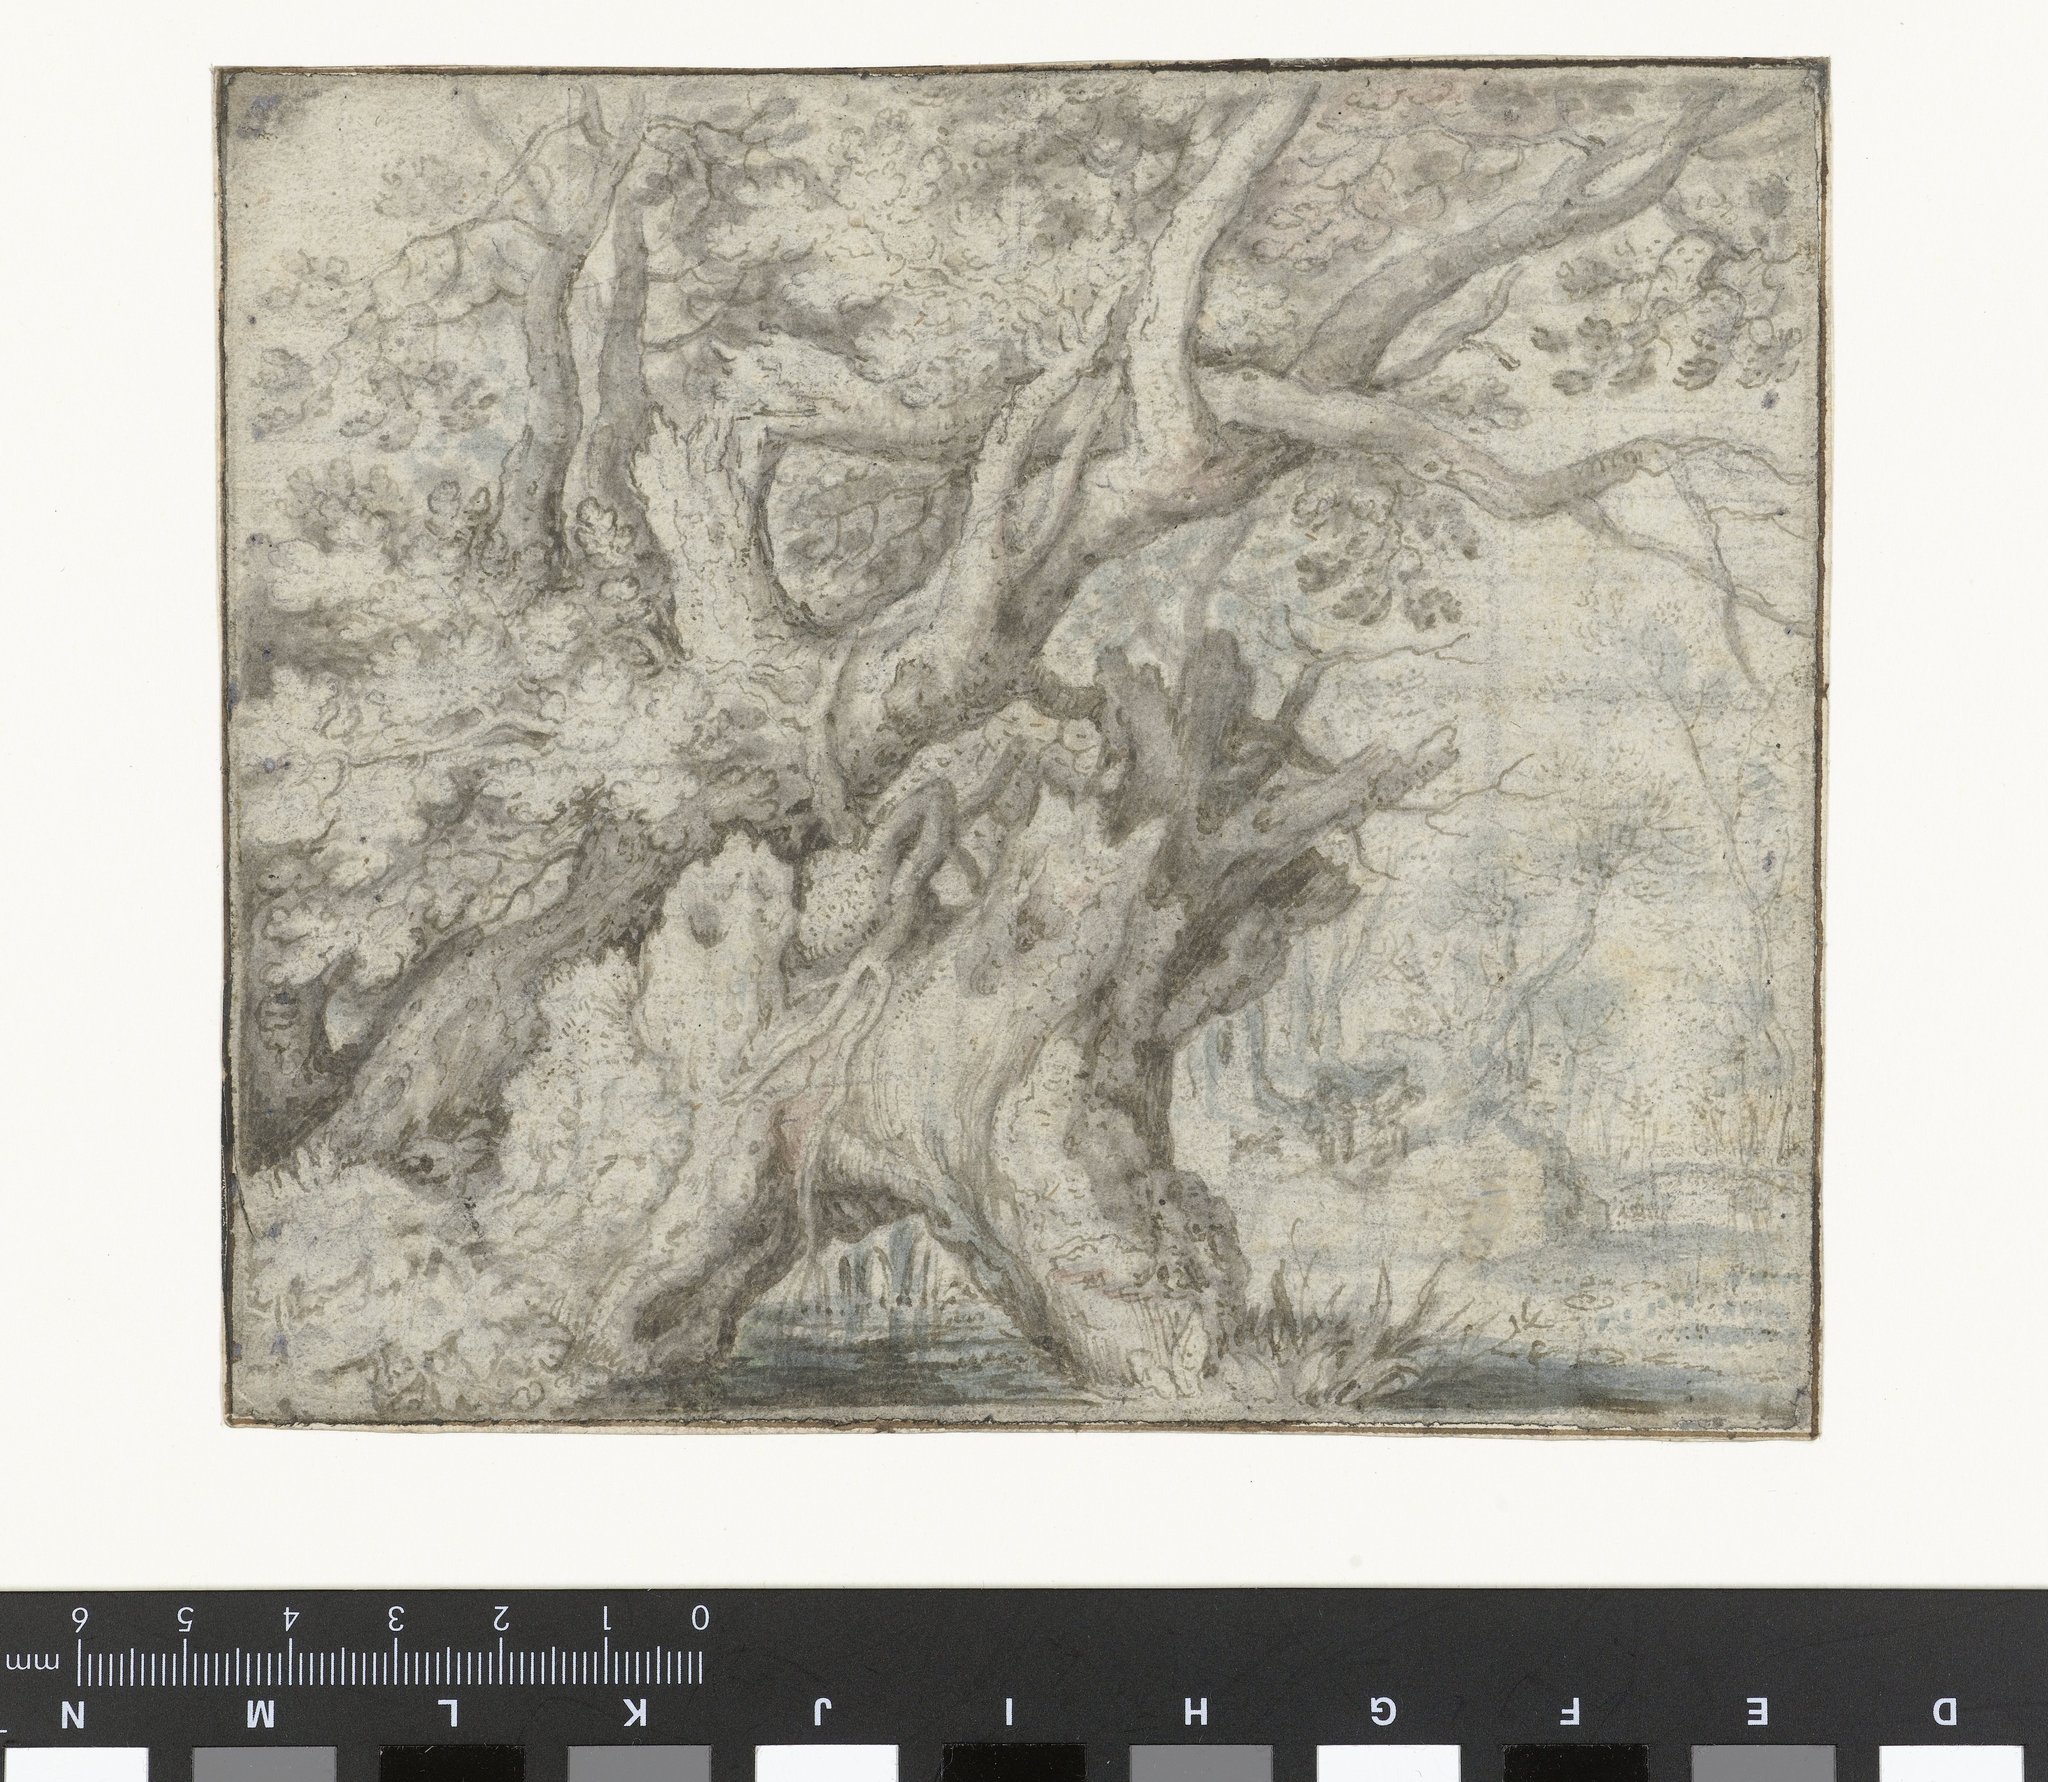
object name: drawing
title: Gnarled Trees near the Water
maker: roelant savery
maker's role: draughtsman, painter, print maker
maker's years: 1576-1639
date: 1605-1610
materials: chalk, ink, paper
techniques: brush, pen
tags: dog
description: In this drawing Savery renders oddities of nature in an almost hair-raising manner. His gnarled trees resemble demonic creatures possessed by a will of their own. The drawing is squared in black chalk so that it can be transferred to a larger format. Perhaps it was intended as a preliminary study for a drawing or painting of larger dimensions